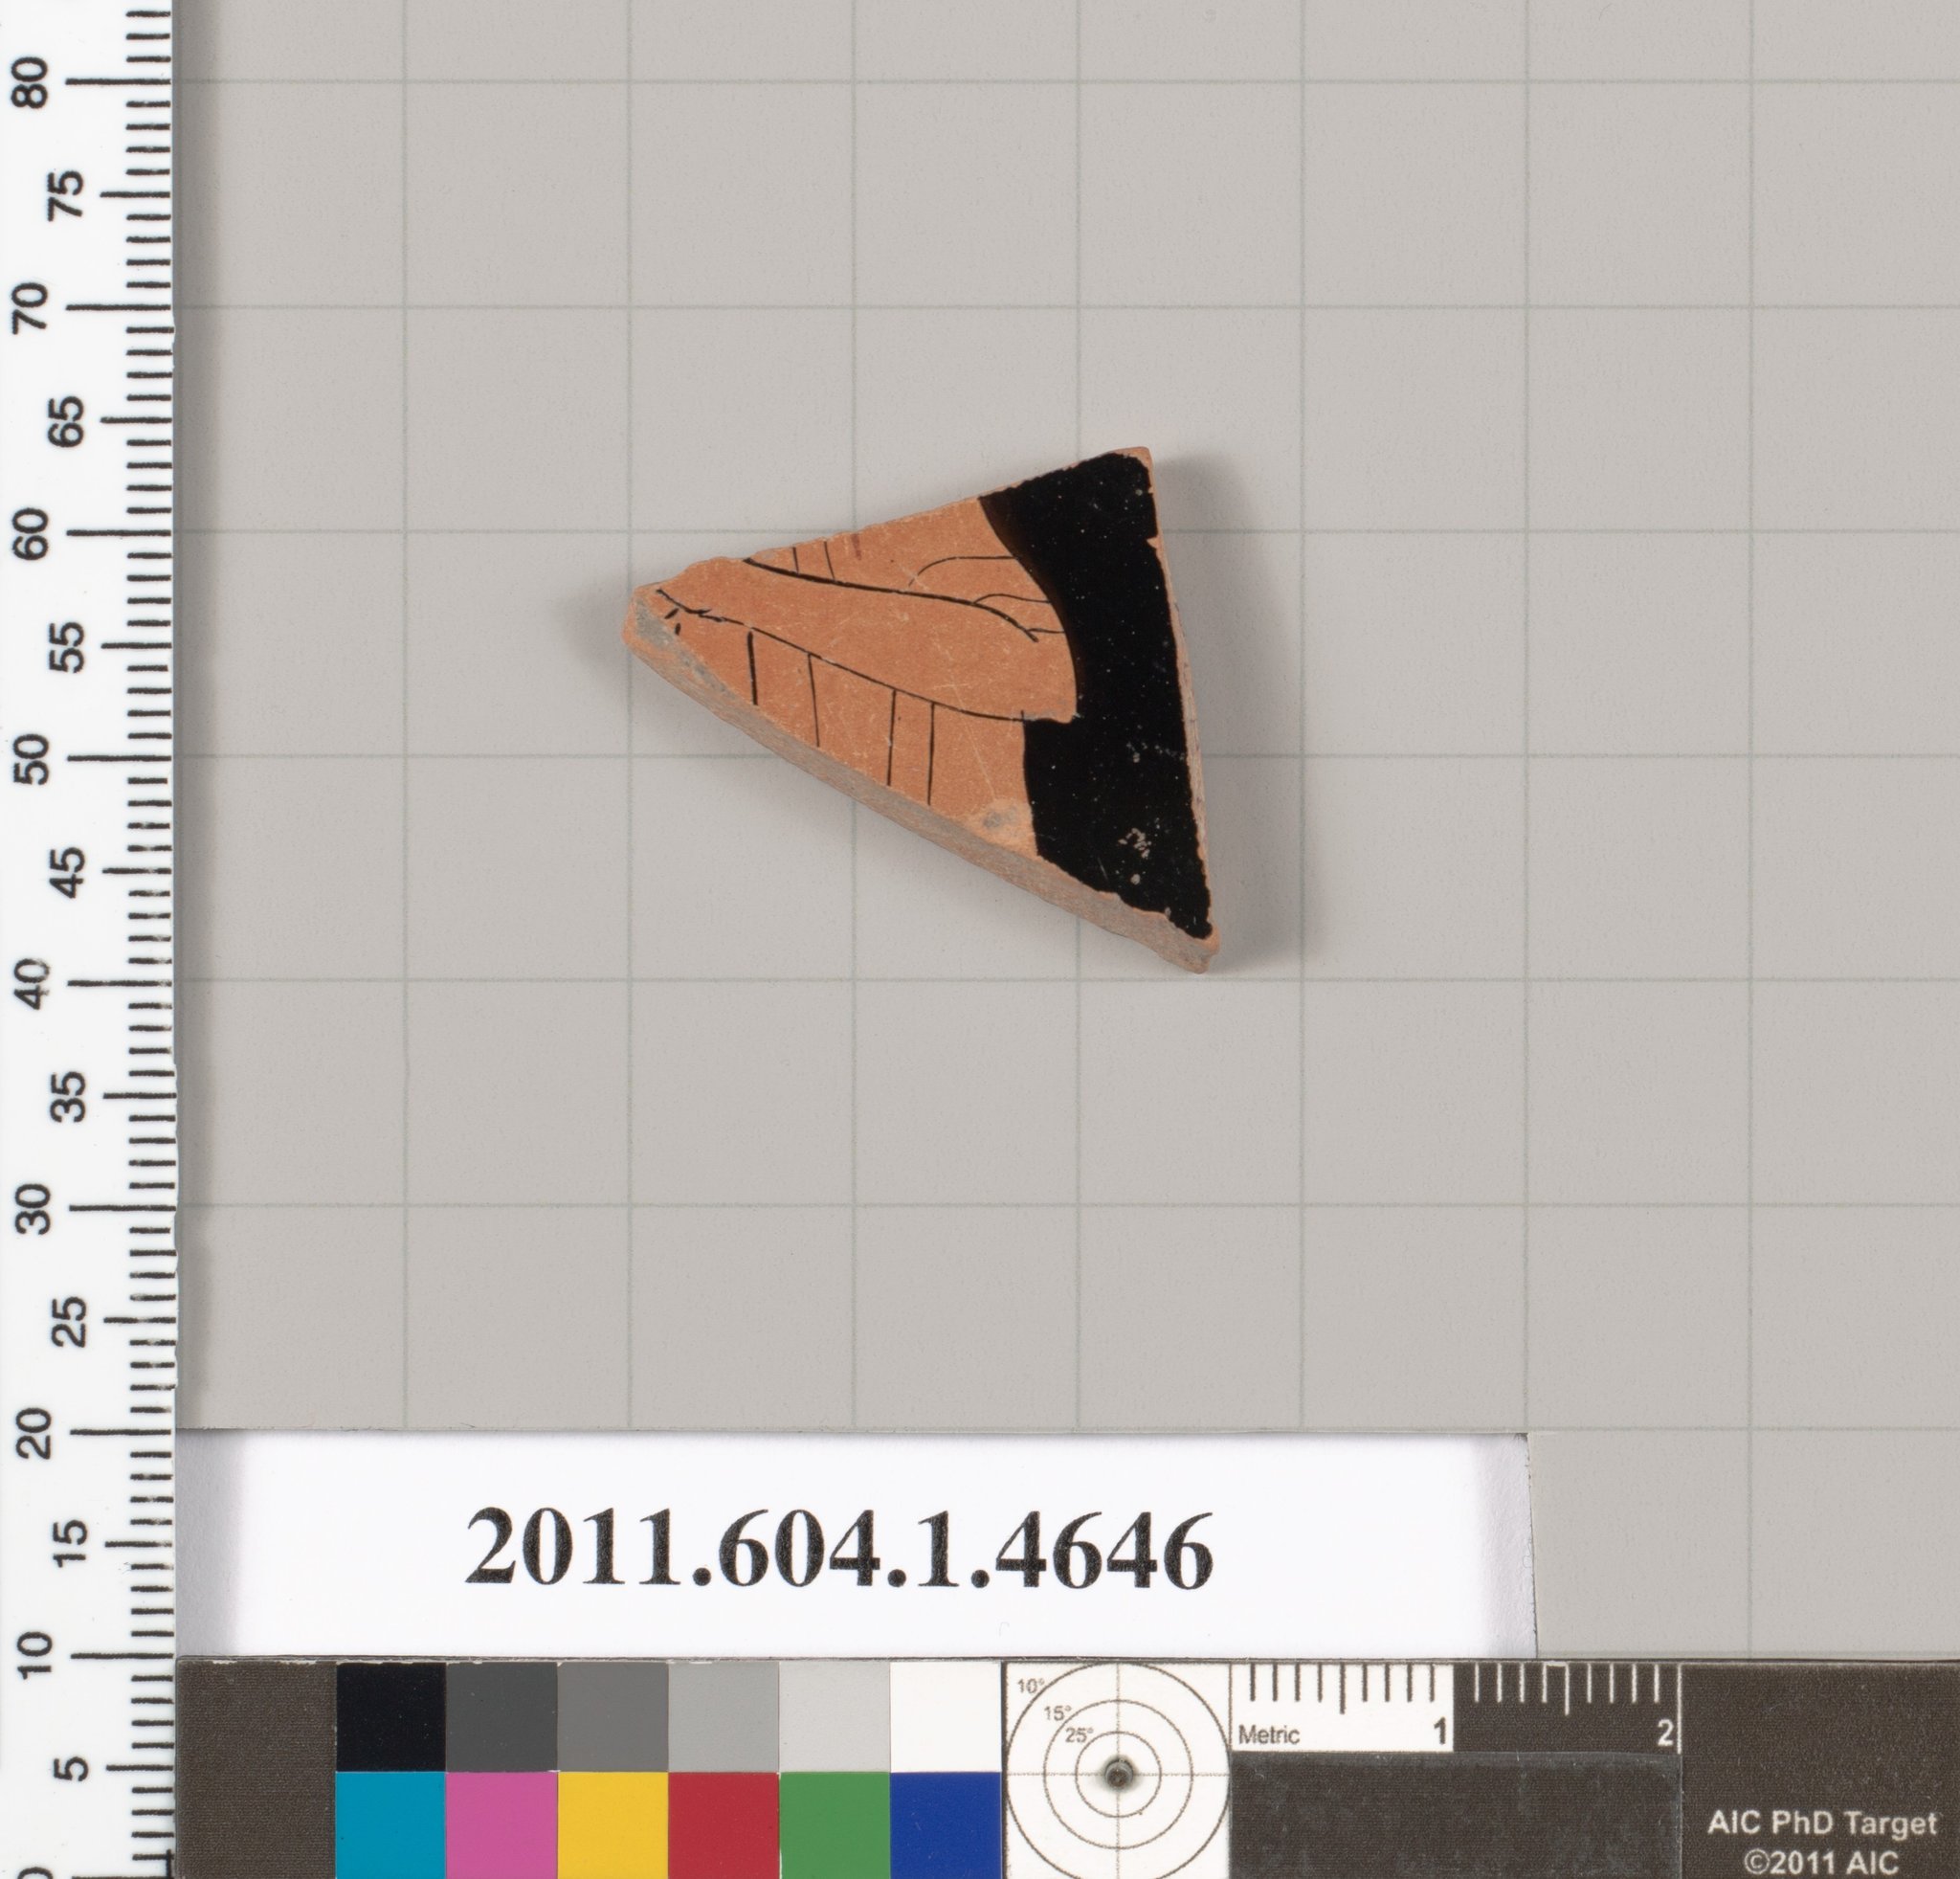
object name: kylix fragment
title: Terracotta fragment of a kylix (drinking cup)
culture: greek, attic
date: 475-451 BCE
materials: terracotta